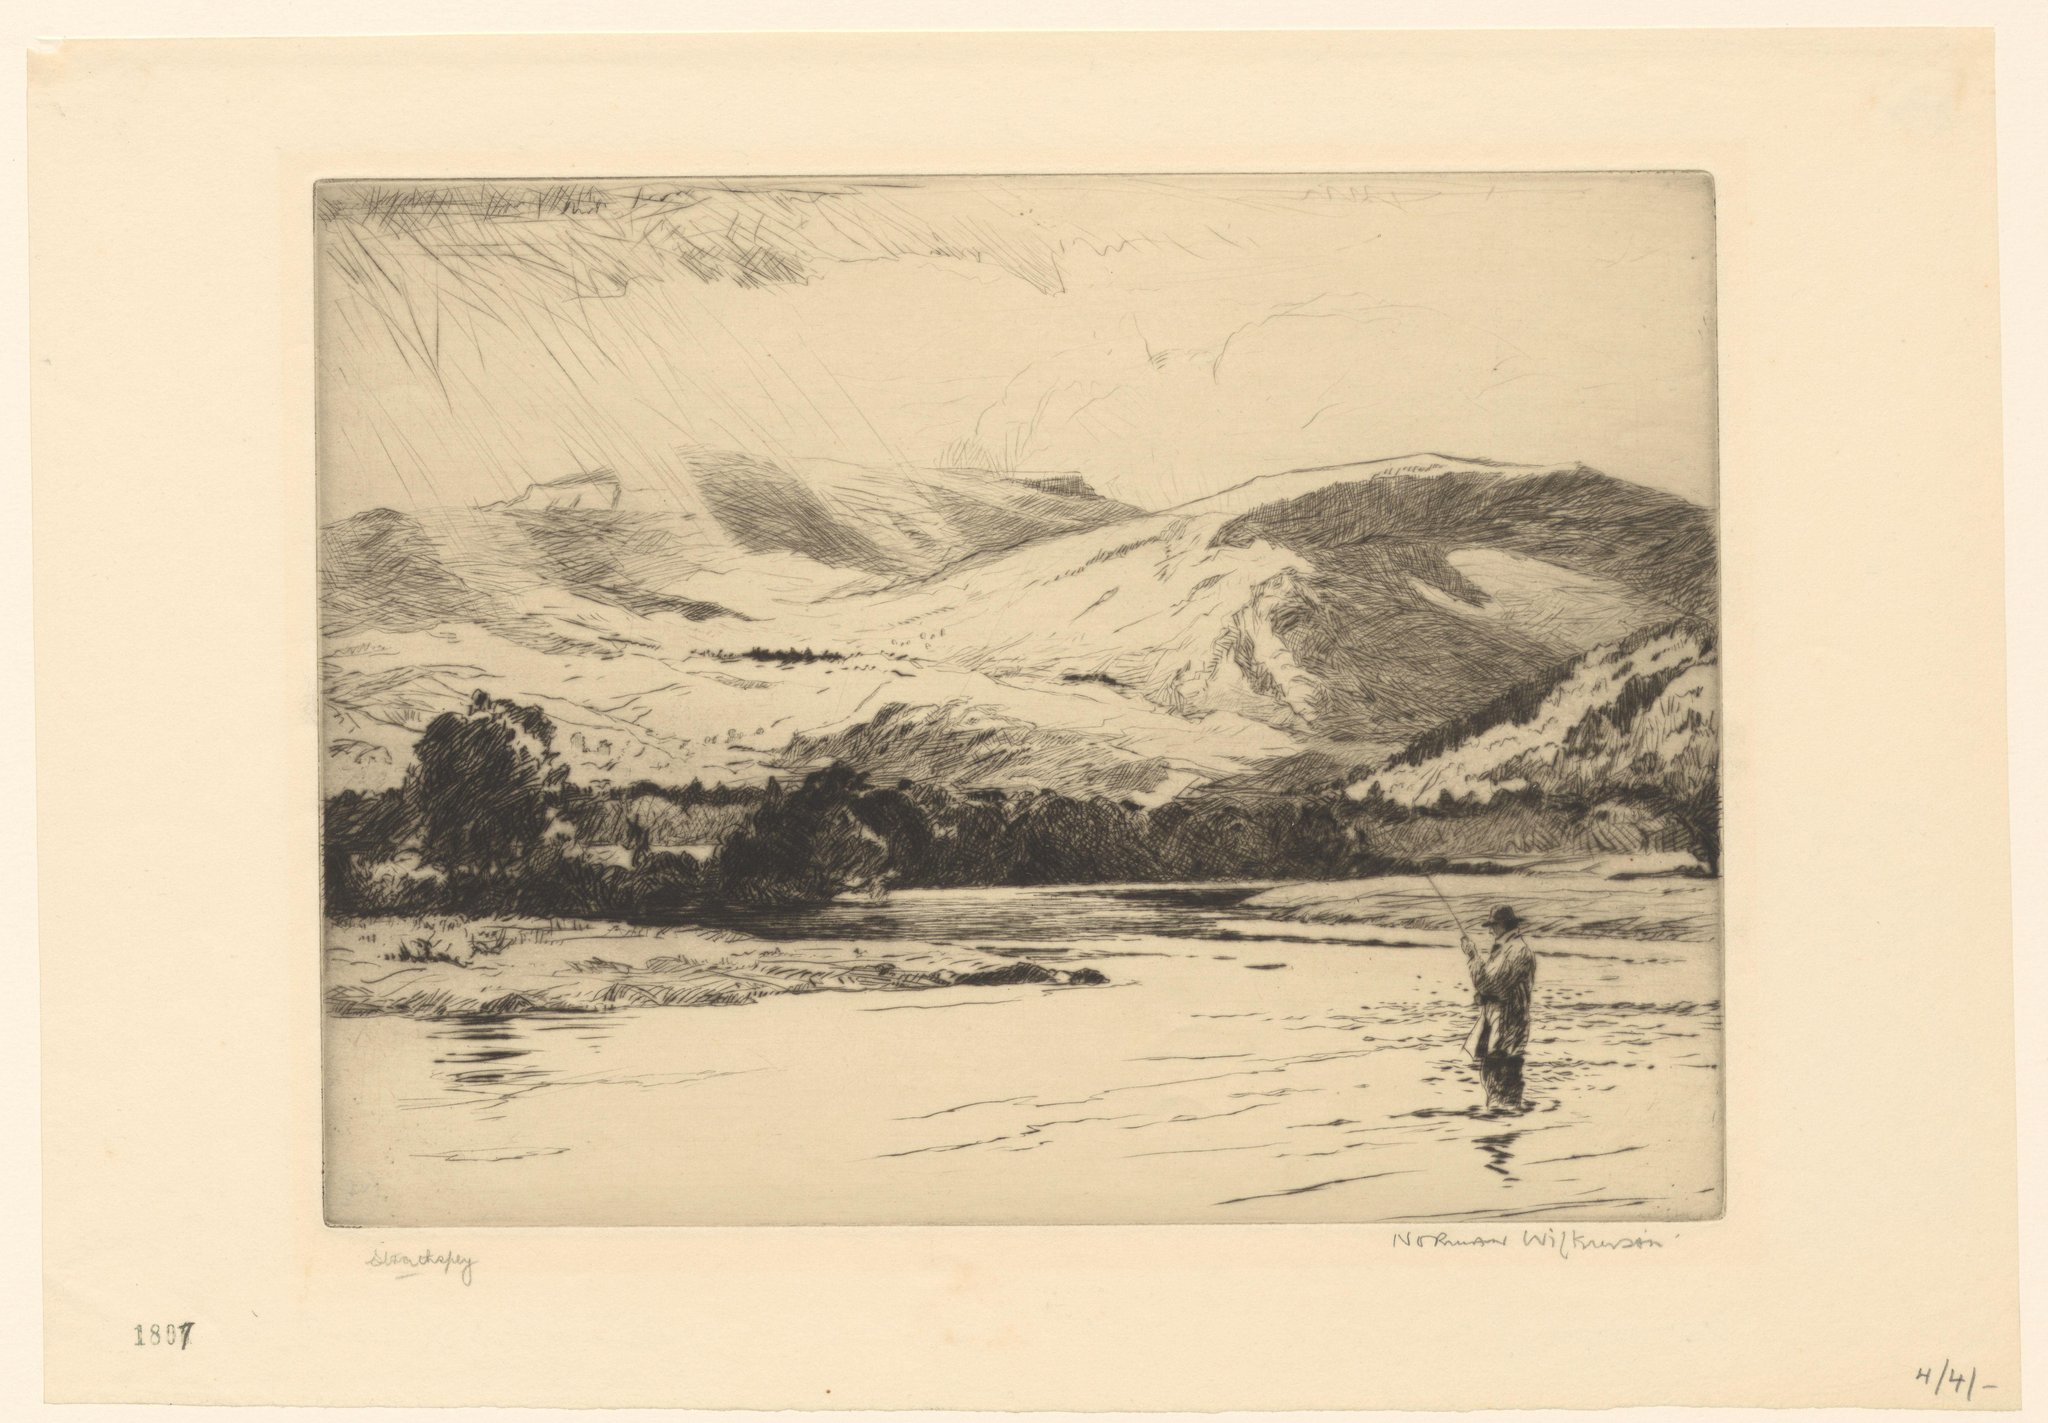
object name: print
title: Heuvelachtig landschap met hengelaar staande in rivier Spey in Strathspey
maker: norman wilkinson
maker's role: print maker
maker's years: 1882-1934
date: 1930-1940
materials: paper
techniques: drypoint, intaglio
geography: england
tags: river, (high) hill, angling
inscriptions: collector's mark: Lugt 2228, collector's mark: Lugt 2760, collector's mark: Lugt 5101, inscription: ‘Strathspey’, signature: ‘Norman Wilkinson’